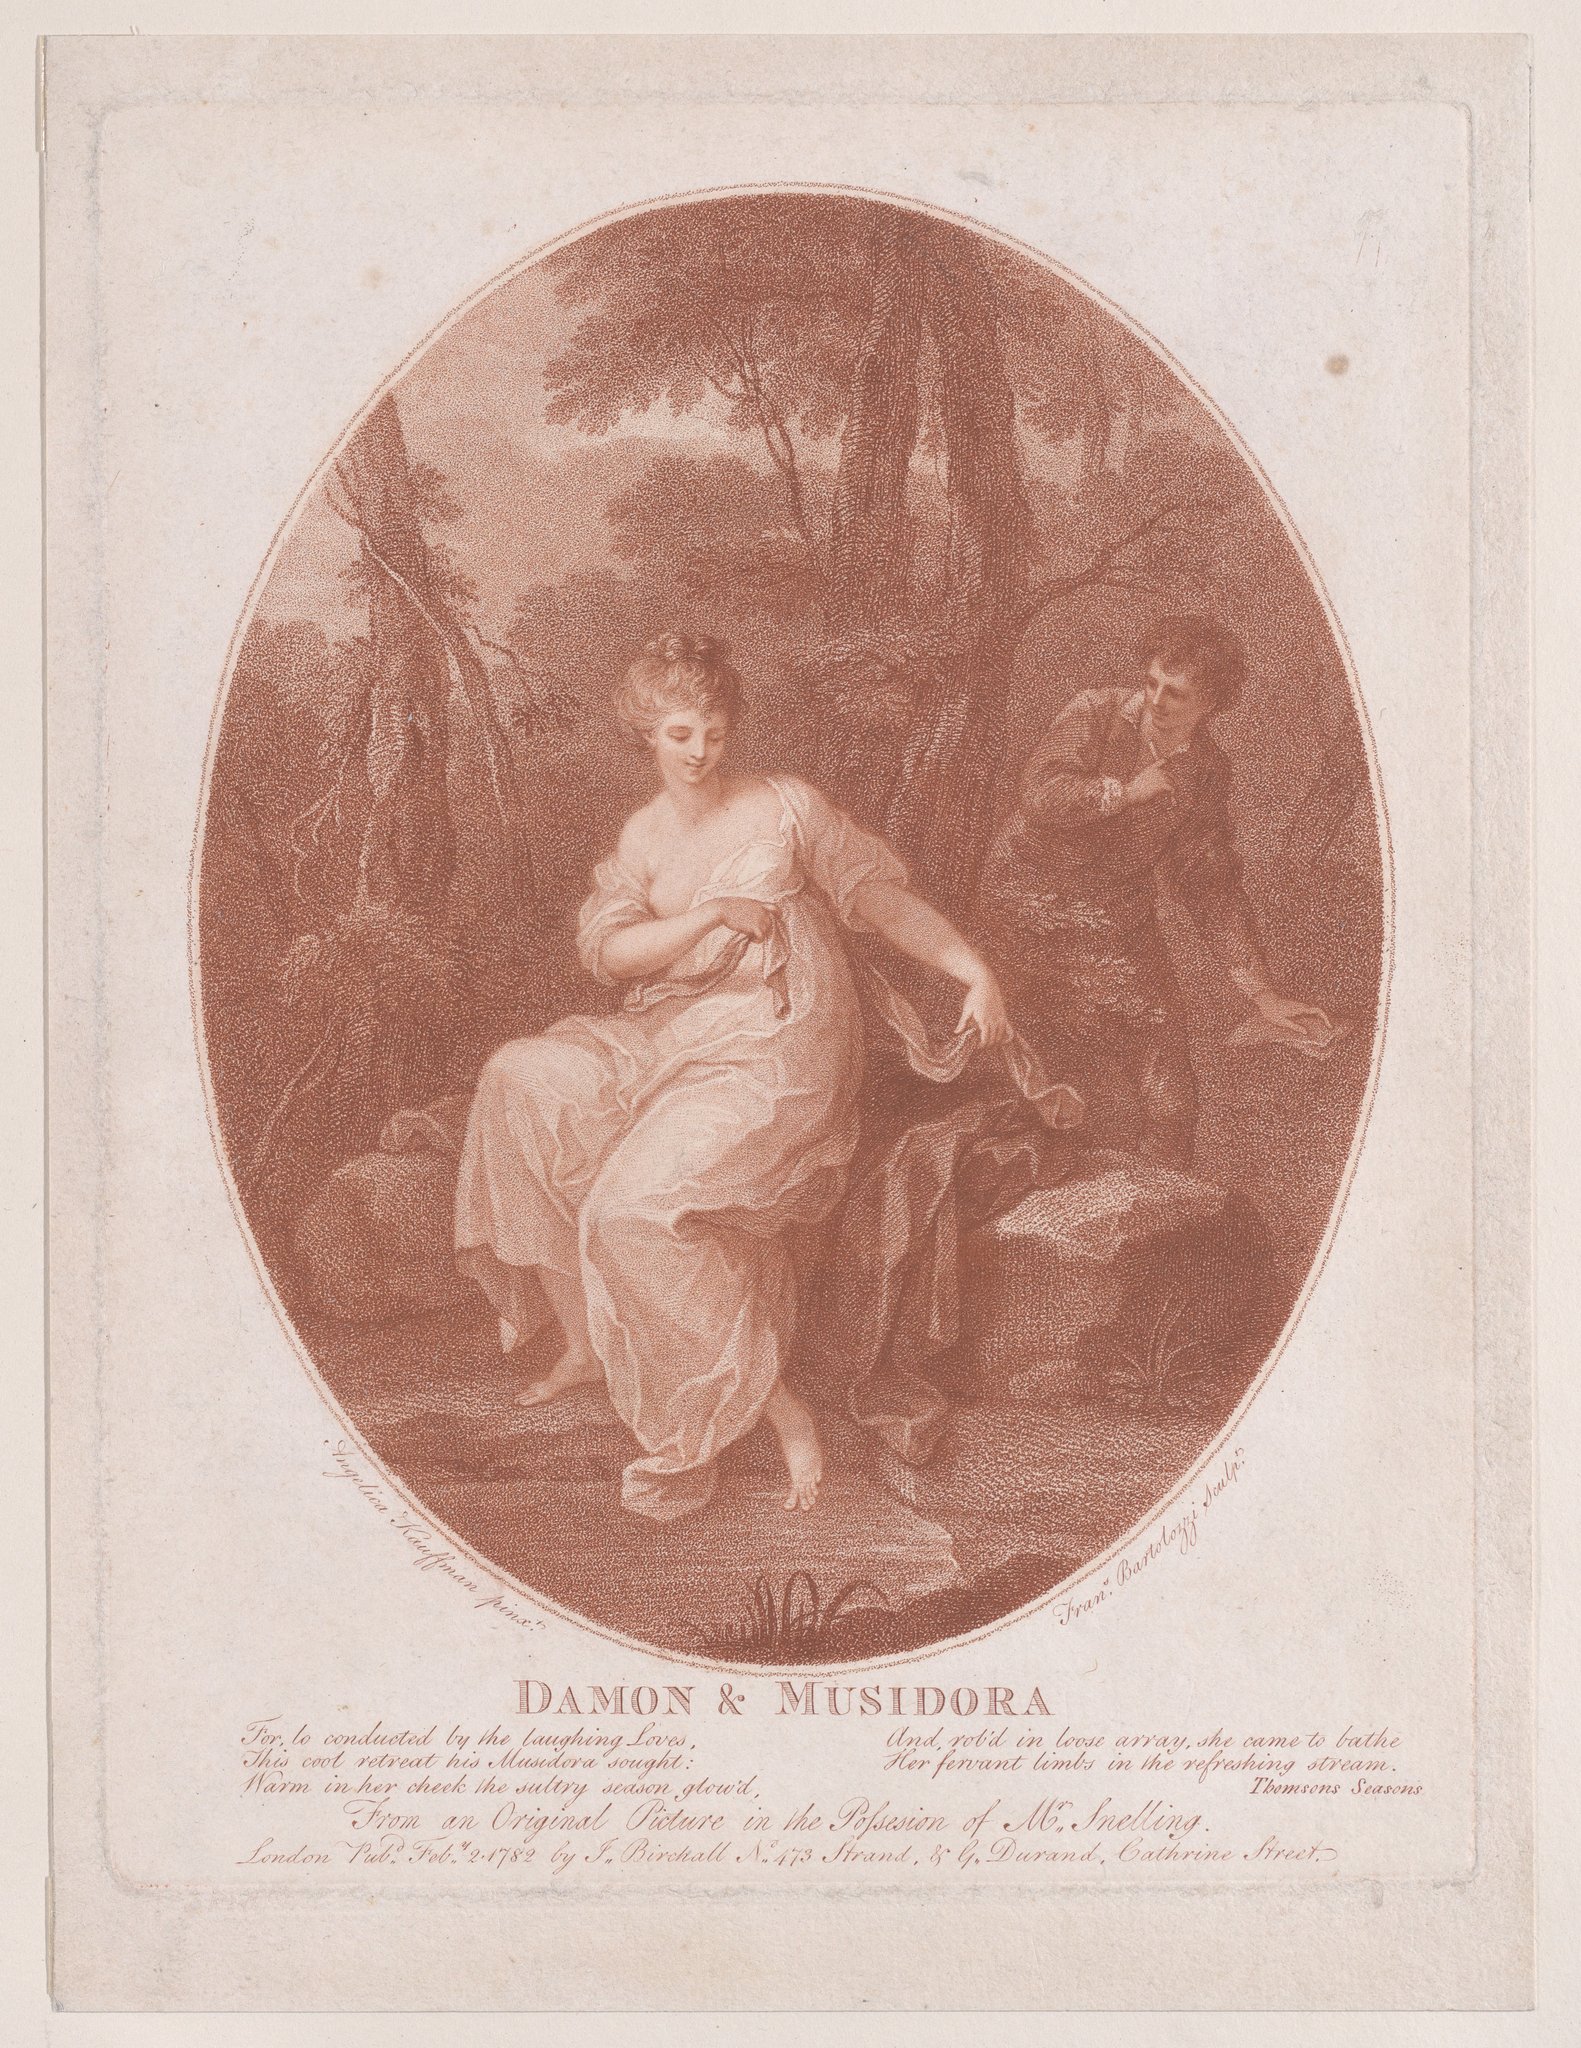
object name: print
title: Damon and Musidora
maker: francesco bartolozzi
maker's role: artist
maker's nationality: italian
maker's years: 1728-1815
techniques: printing, engraving